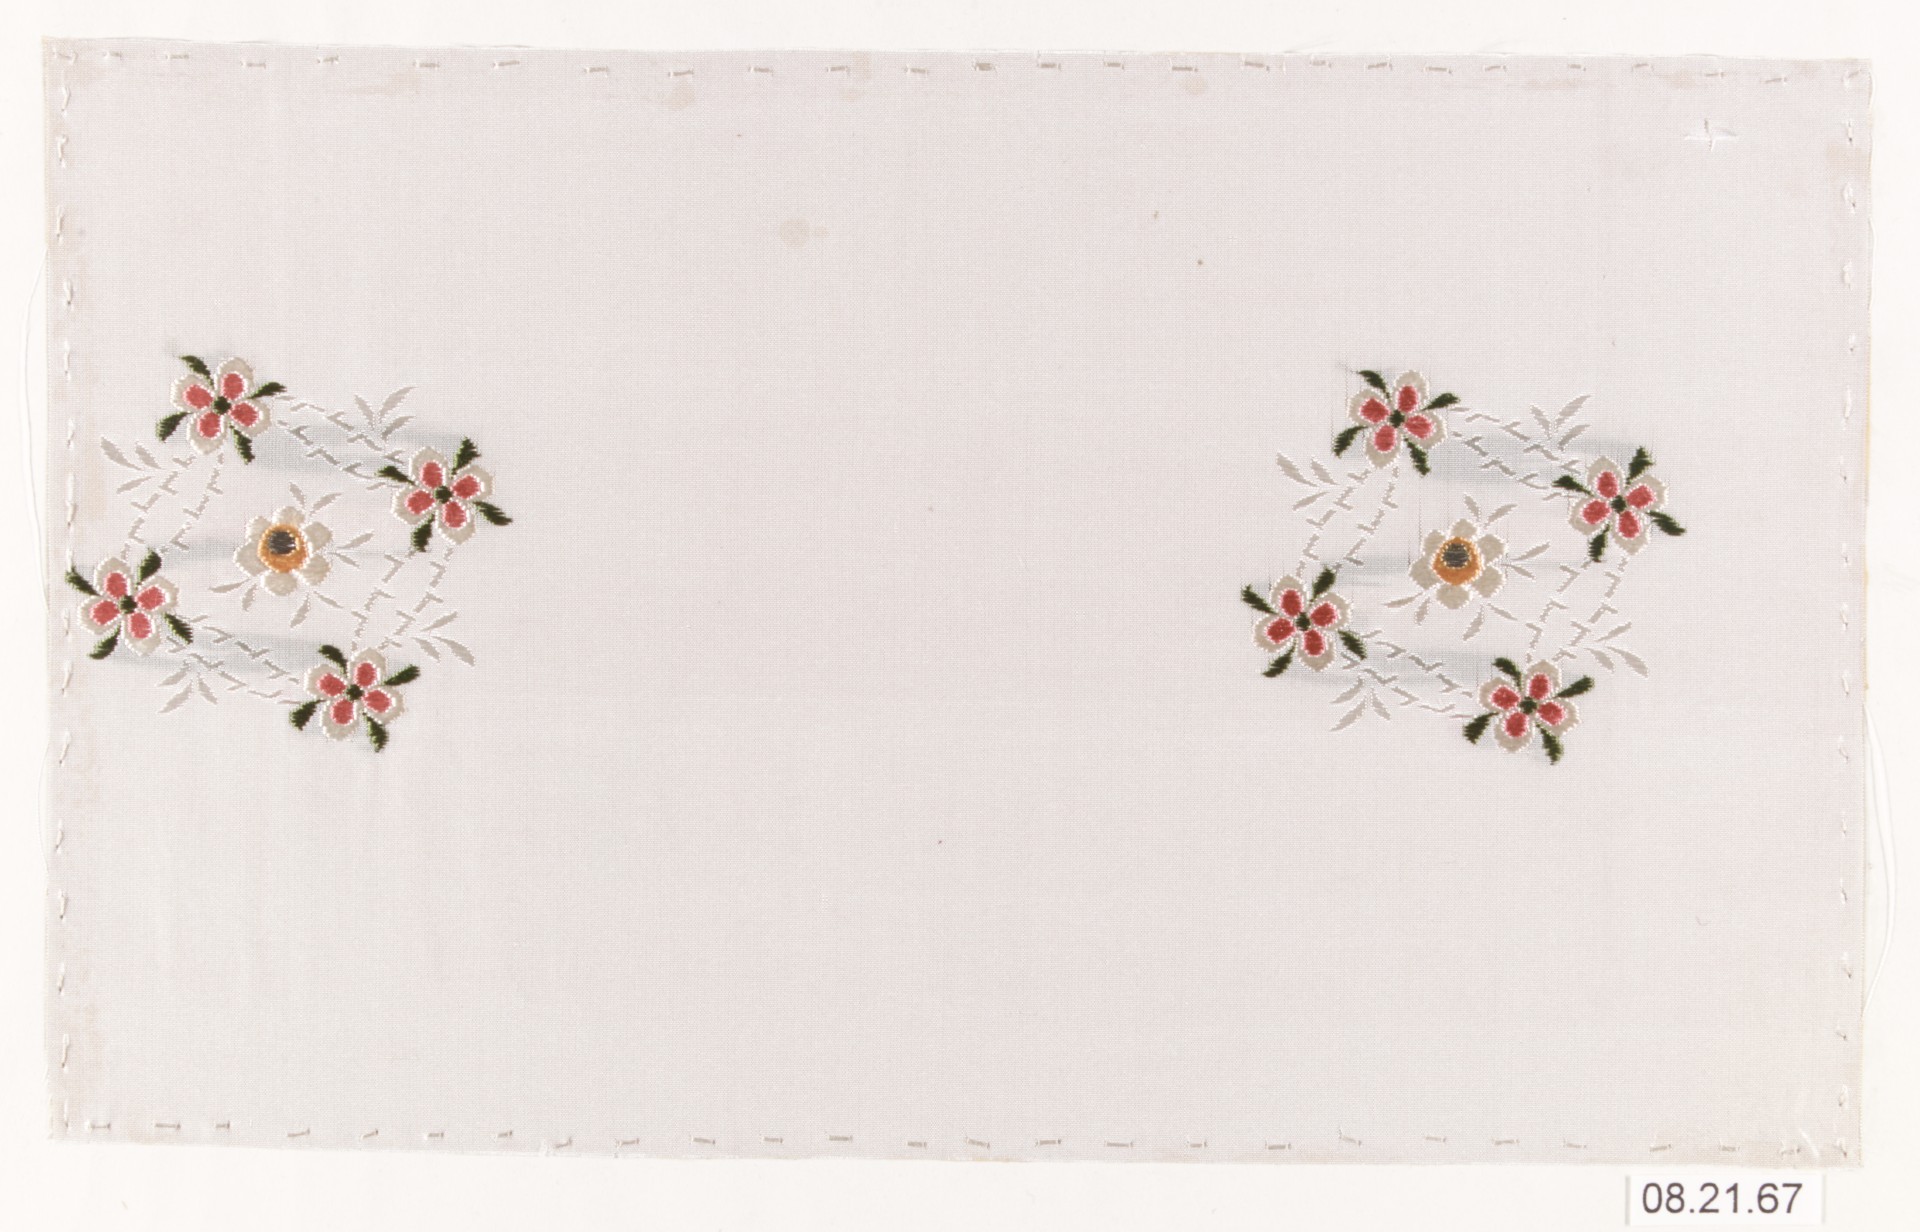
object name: textile sample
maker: Anonymous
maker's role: designer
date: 1900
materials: silk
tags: flowers